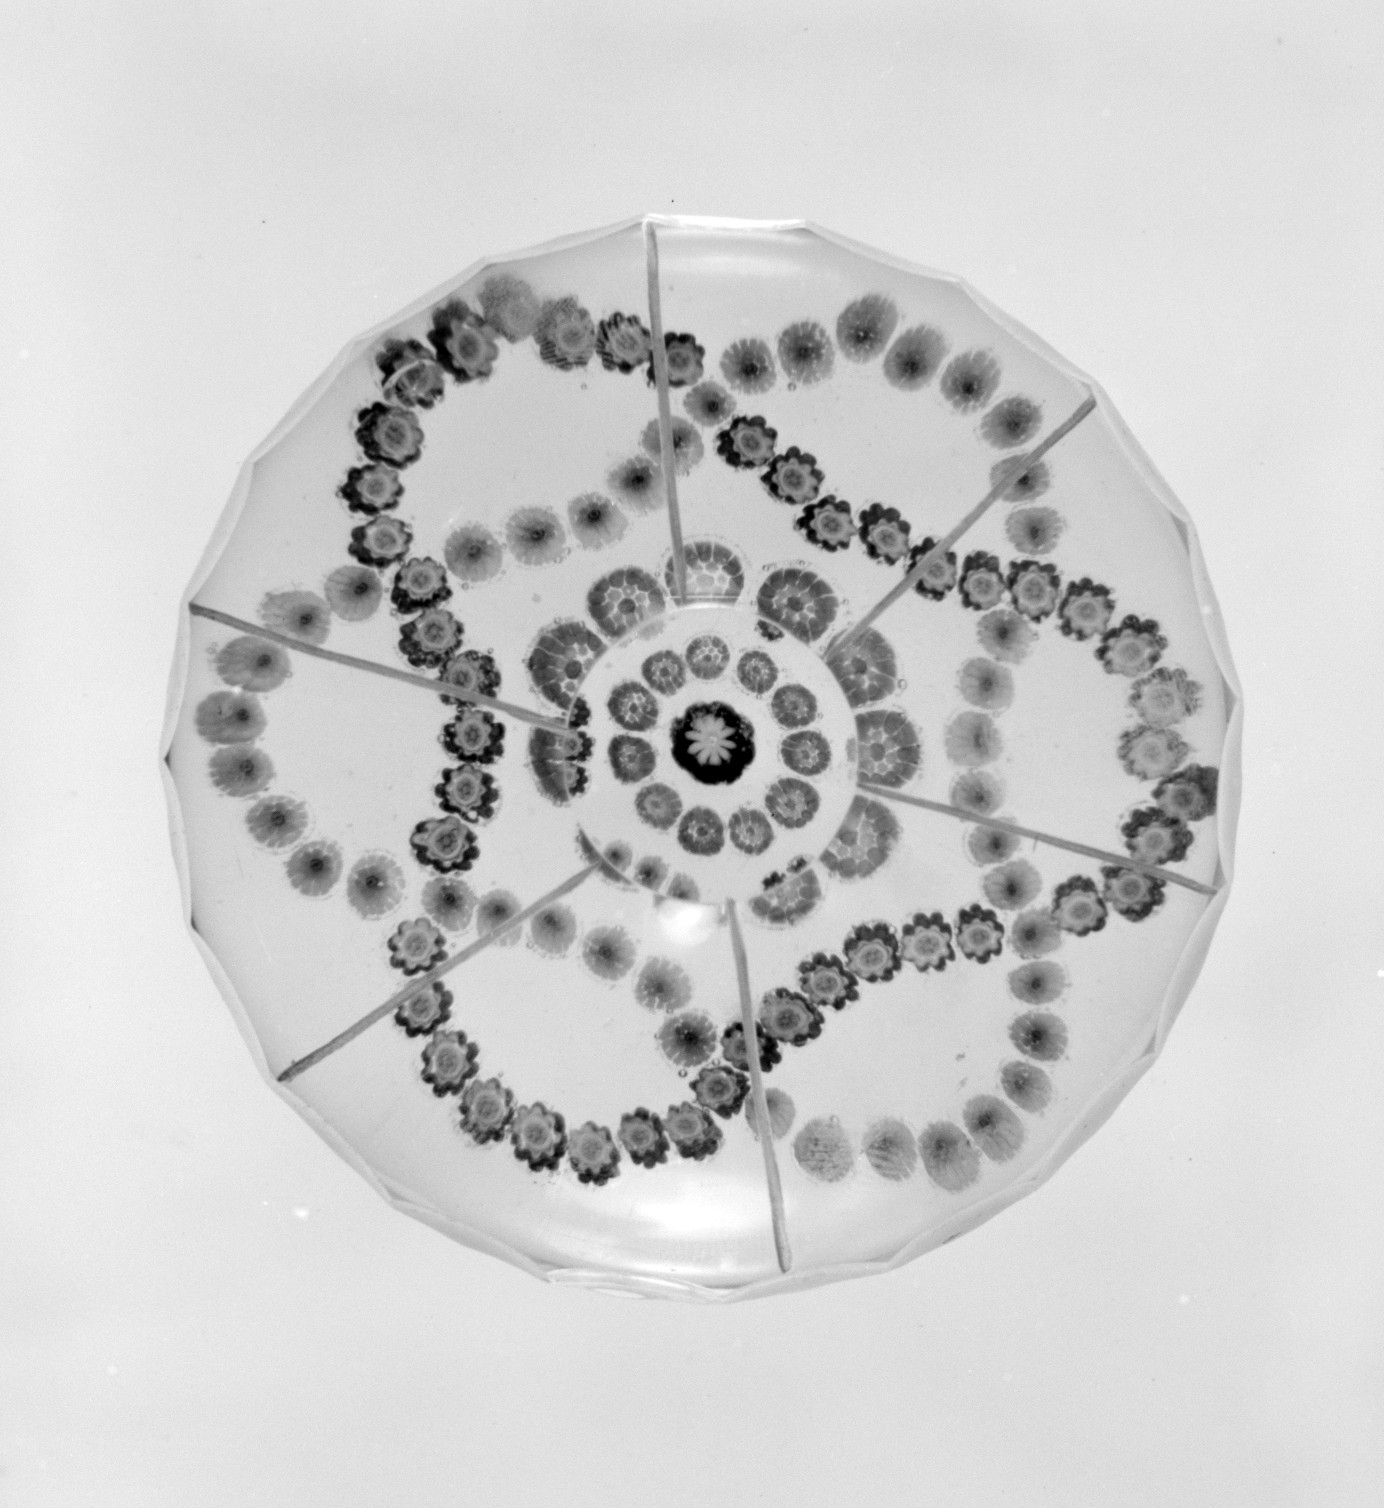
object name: paperweight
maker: baccarat glasshouse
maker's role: maker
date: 1835-1845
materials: glass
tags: flowers